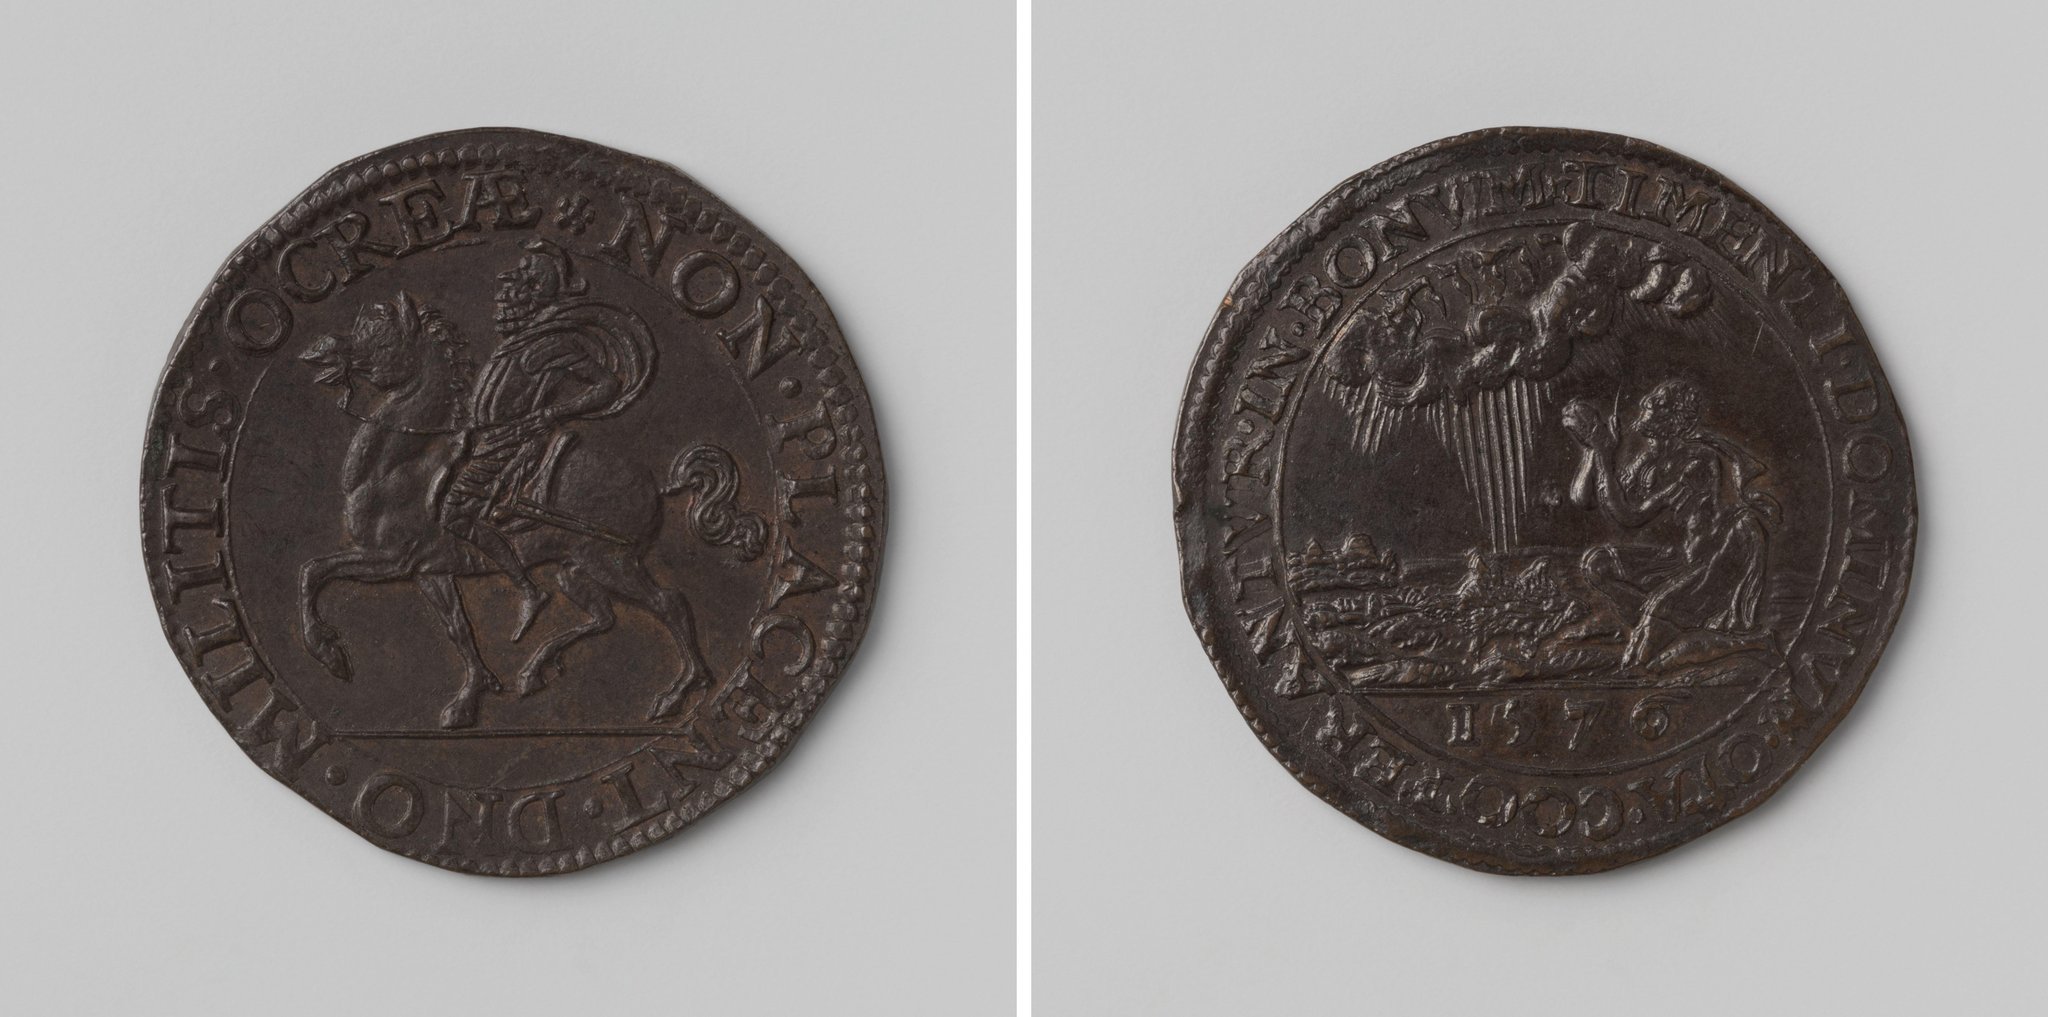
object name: jeton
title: Wonderbaarlijke ommekeer der Nederlandse staatszaken, rekenpenning op de verovering van de Zeeuwse eilanden door de opstandelingen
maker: Anonymous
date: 1576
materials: copper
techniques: striking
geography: dordrecht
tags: zeeland